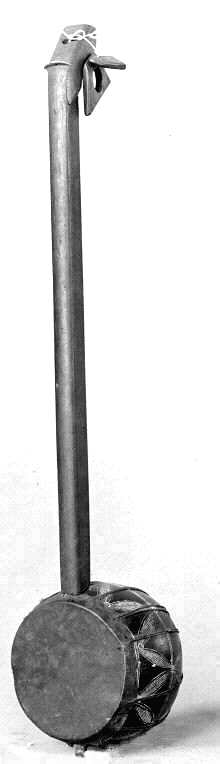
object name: guenbri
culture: algerian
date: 1867-1900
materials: plant material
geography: algeria